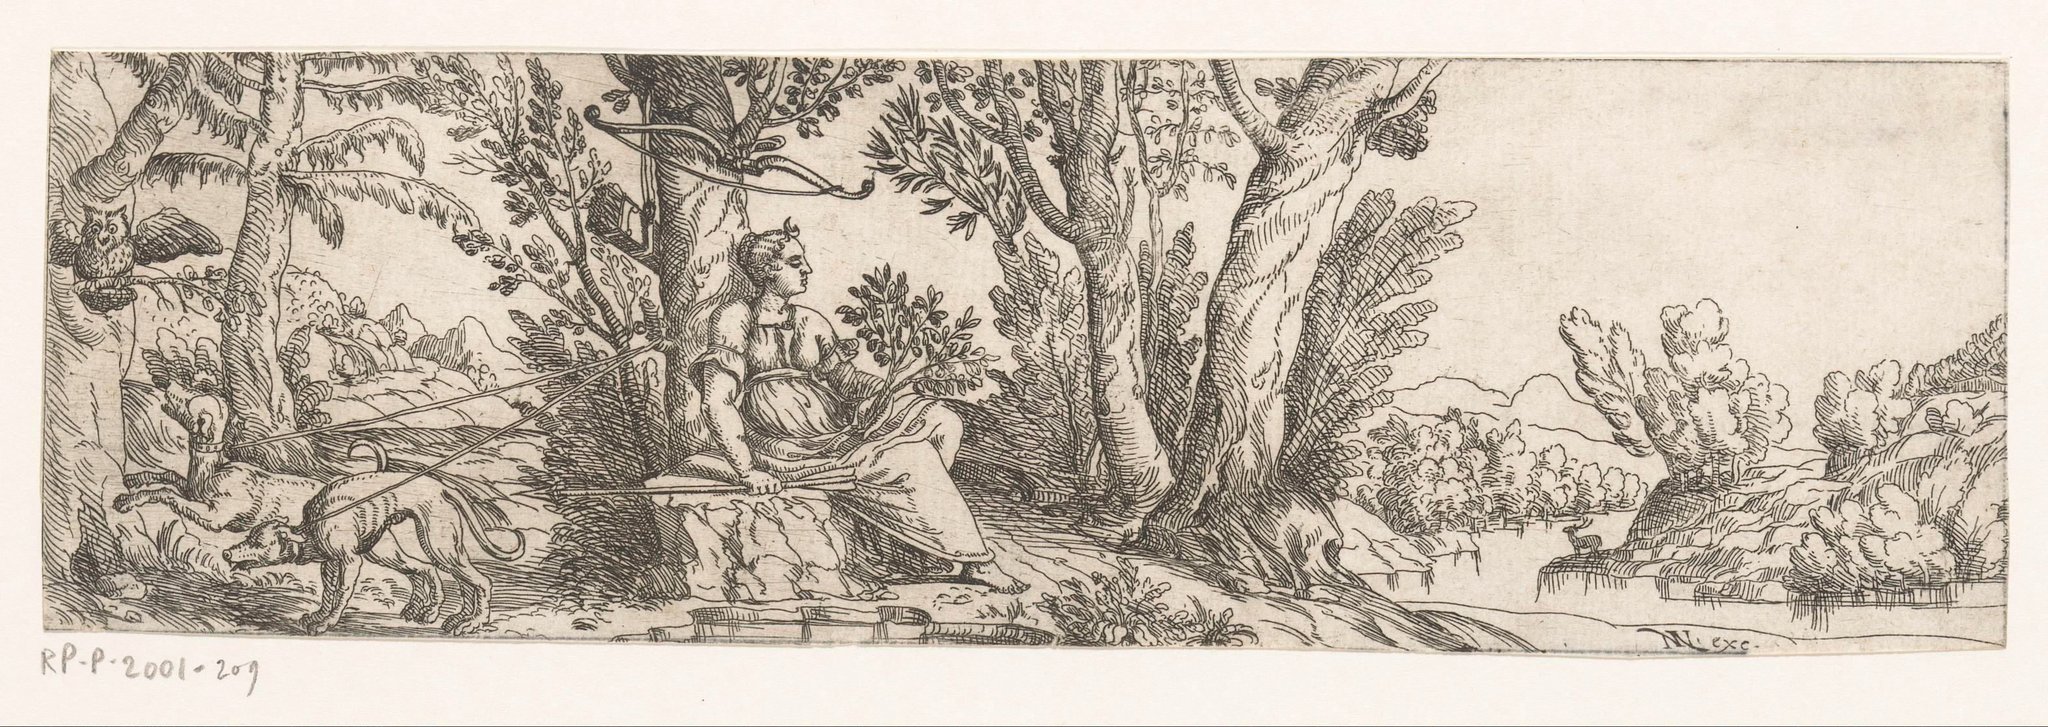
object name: print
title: Landschap met Diana en haar jachthonden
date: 1545-1585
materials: paper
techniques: etching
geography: venice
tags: landscapes, diana hunting, owls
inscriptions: collector's mark: Lugt 2228, collector's mark: Lugt 2760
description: Diana zit tegen een boom geleund en kijkt uit over een rivier. Boven haar hoofd in de boom hangen haar pijl-en-boog. De honden zijn vastgebonden en blaffen naar een uil.